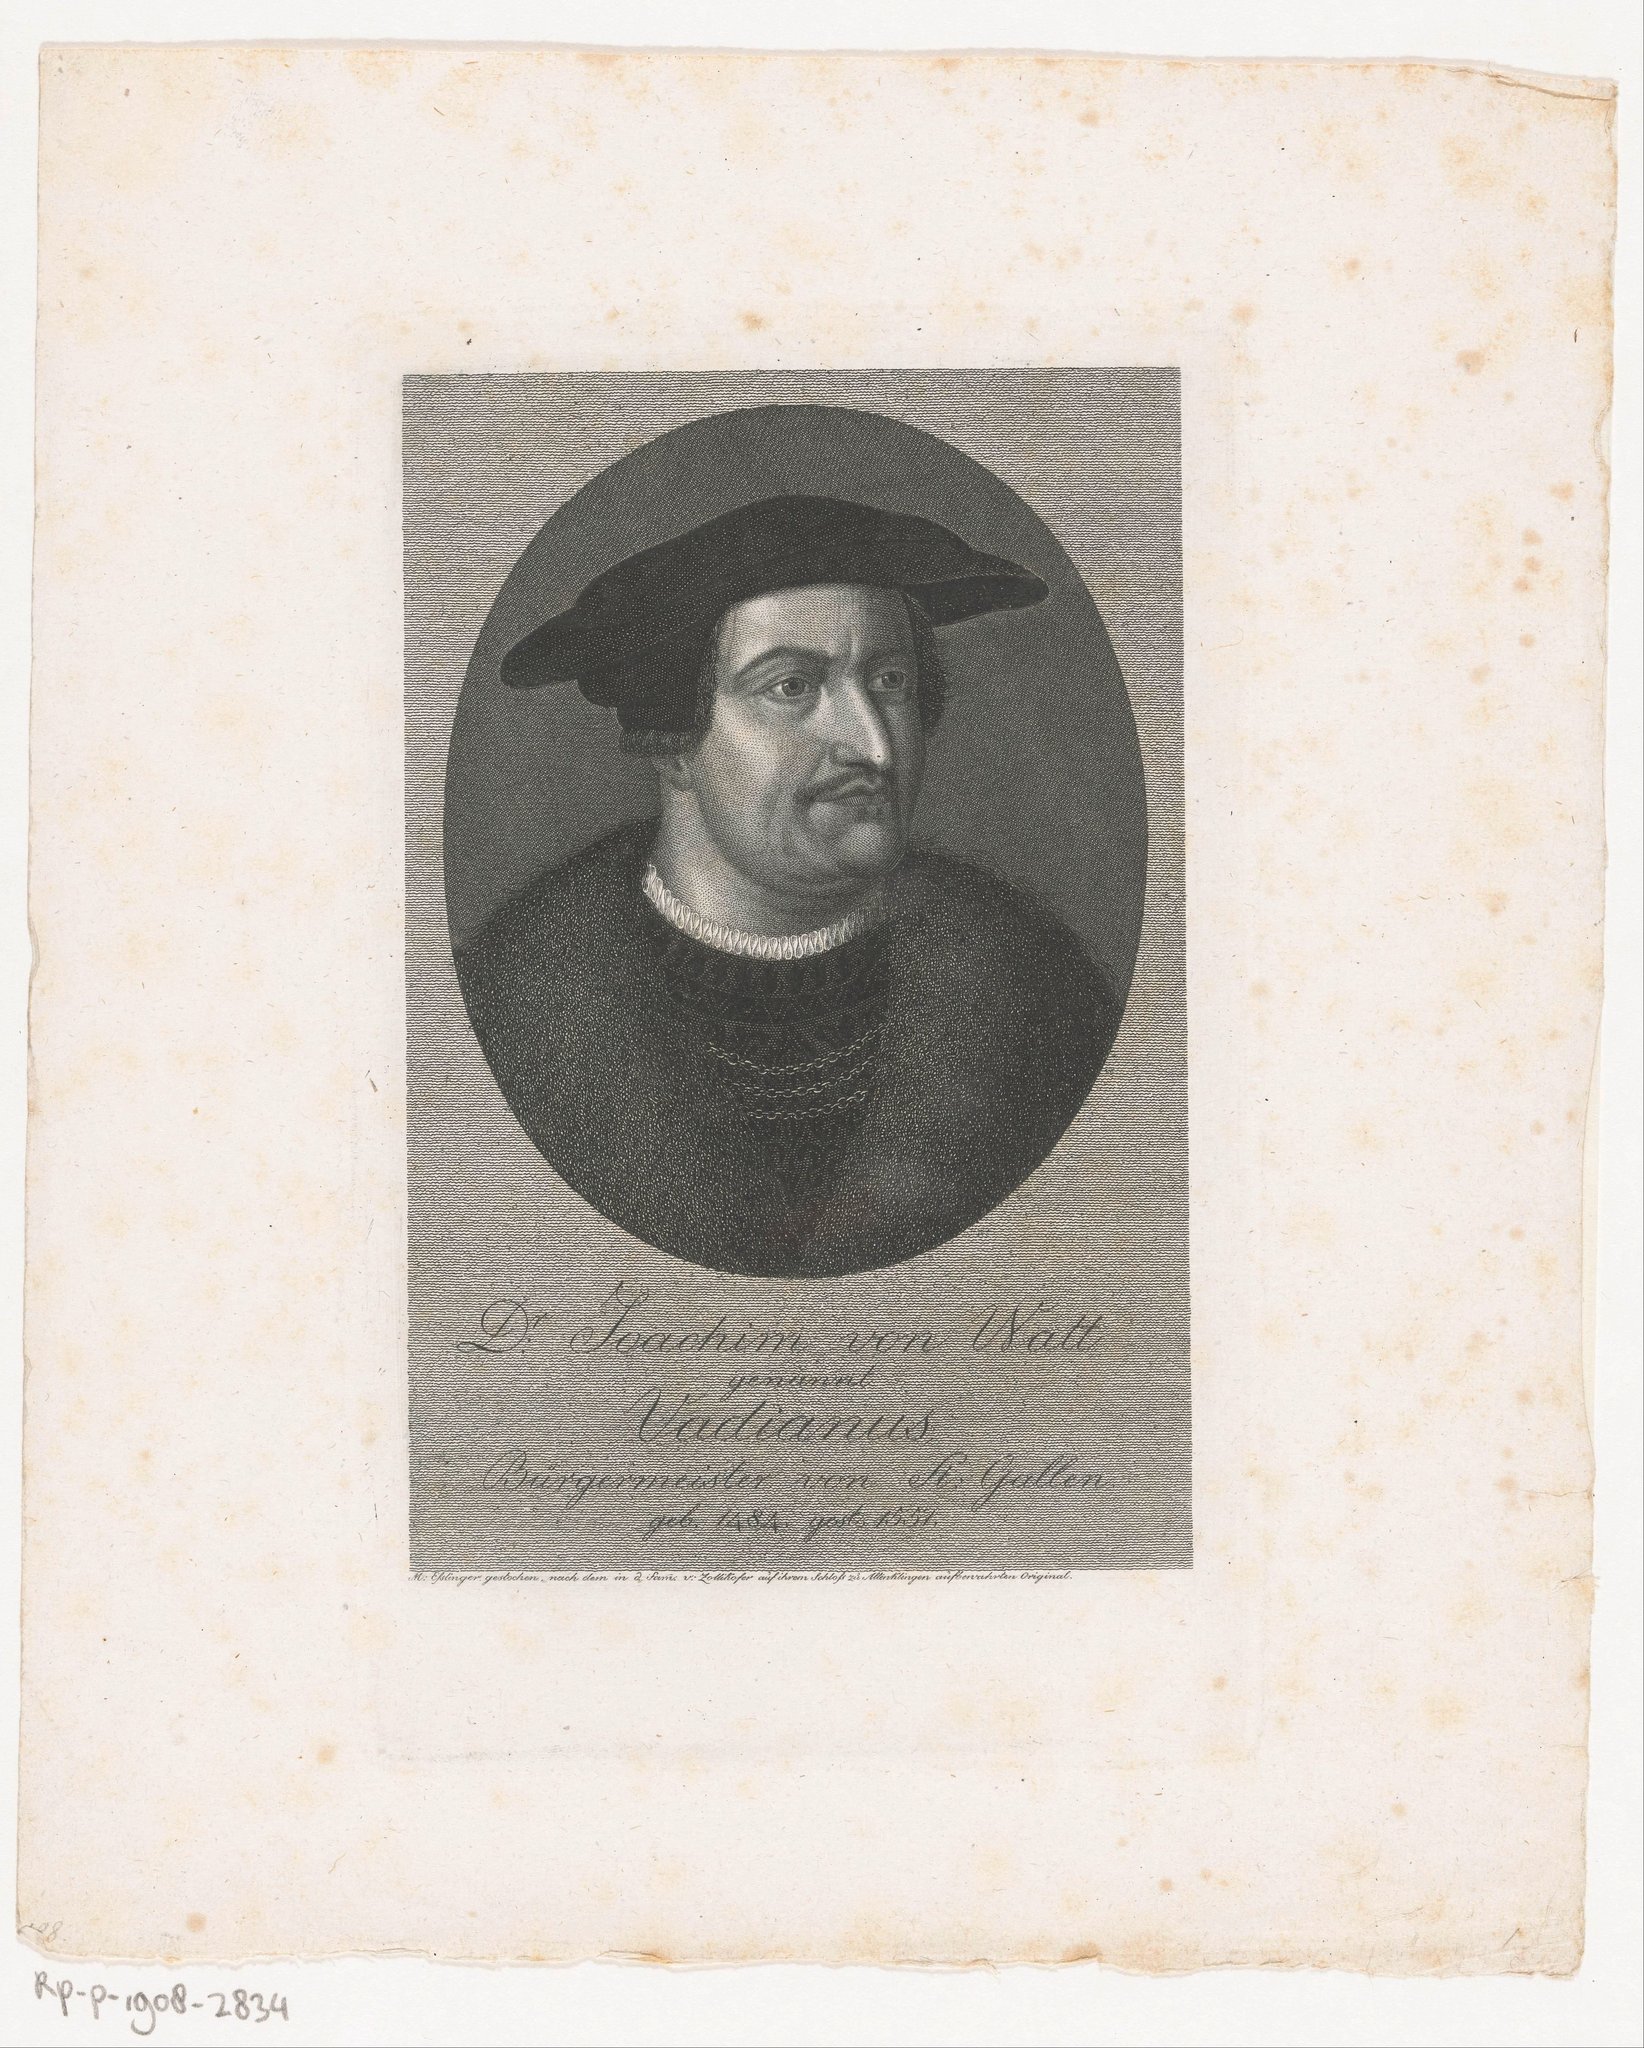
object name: print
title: Portret van Joachim de Watt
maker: martin esslinger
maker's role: print maker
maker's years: 1793-1841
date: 1803-1841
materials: paper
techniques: engraving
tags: historical persons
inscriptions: collector's mark: Lugt 2228